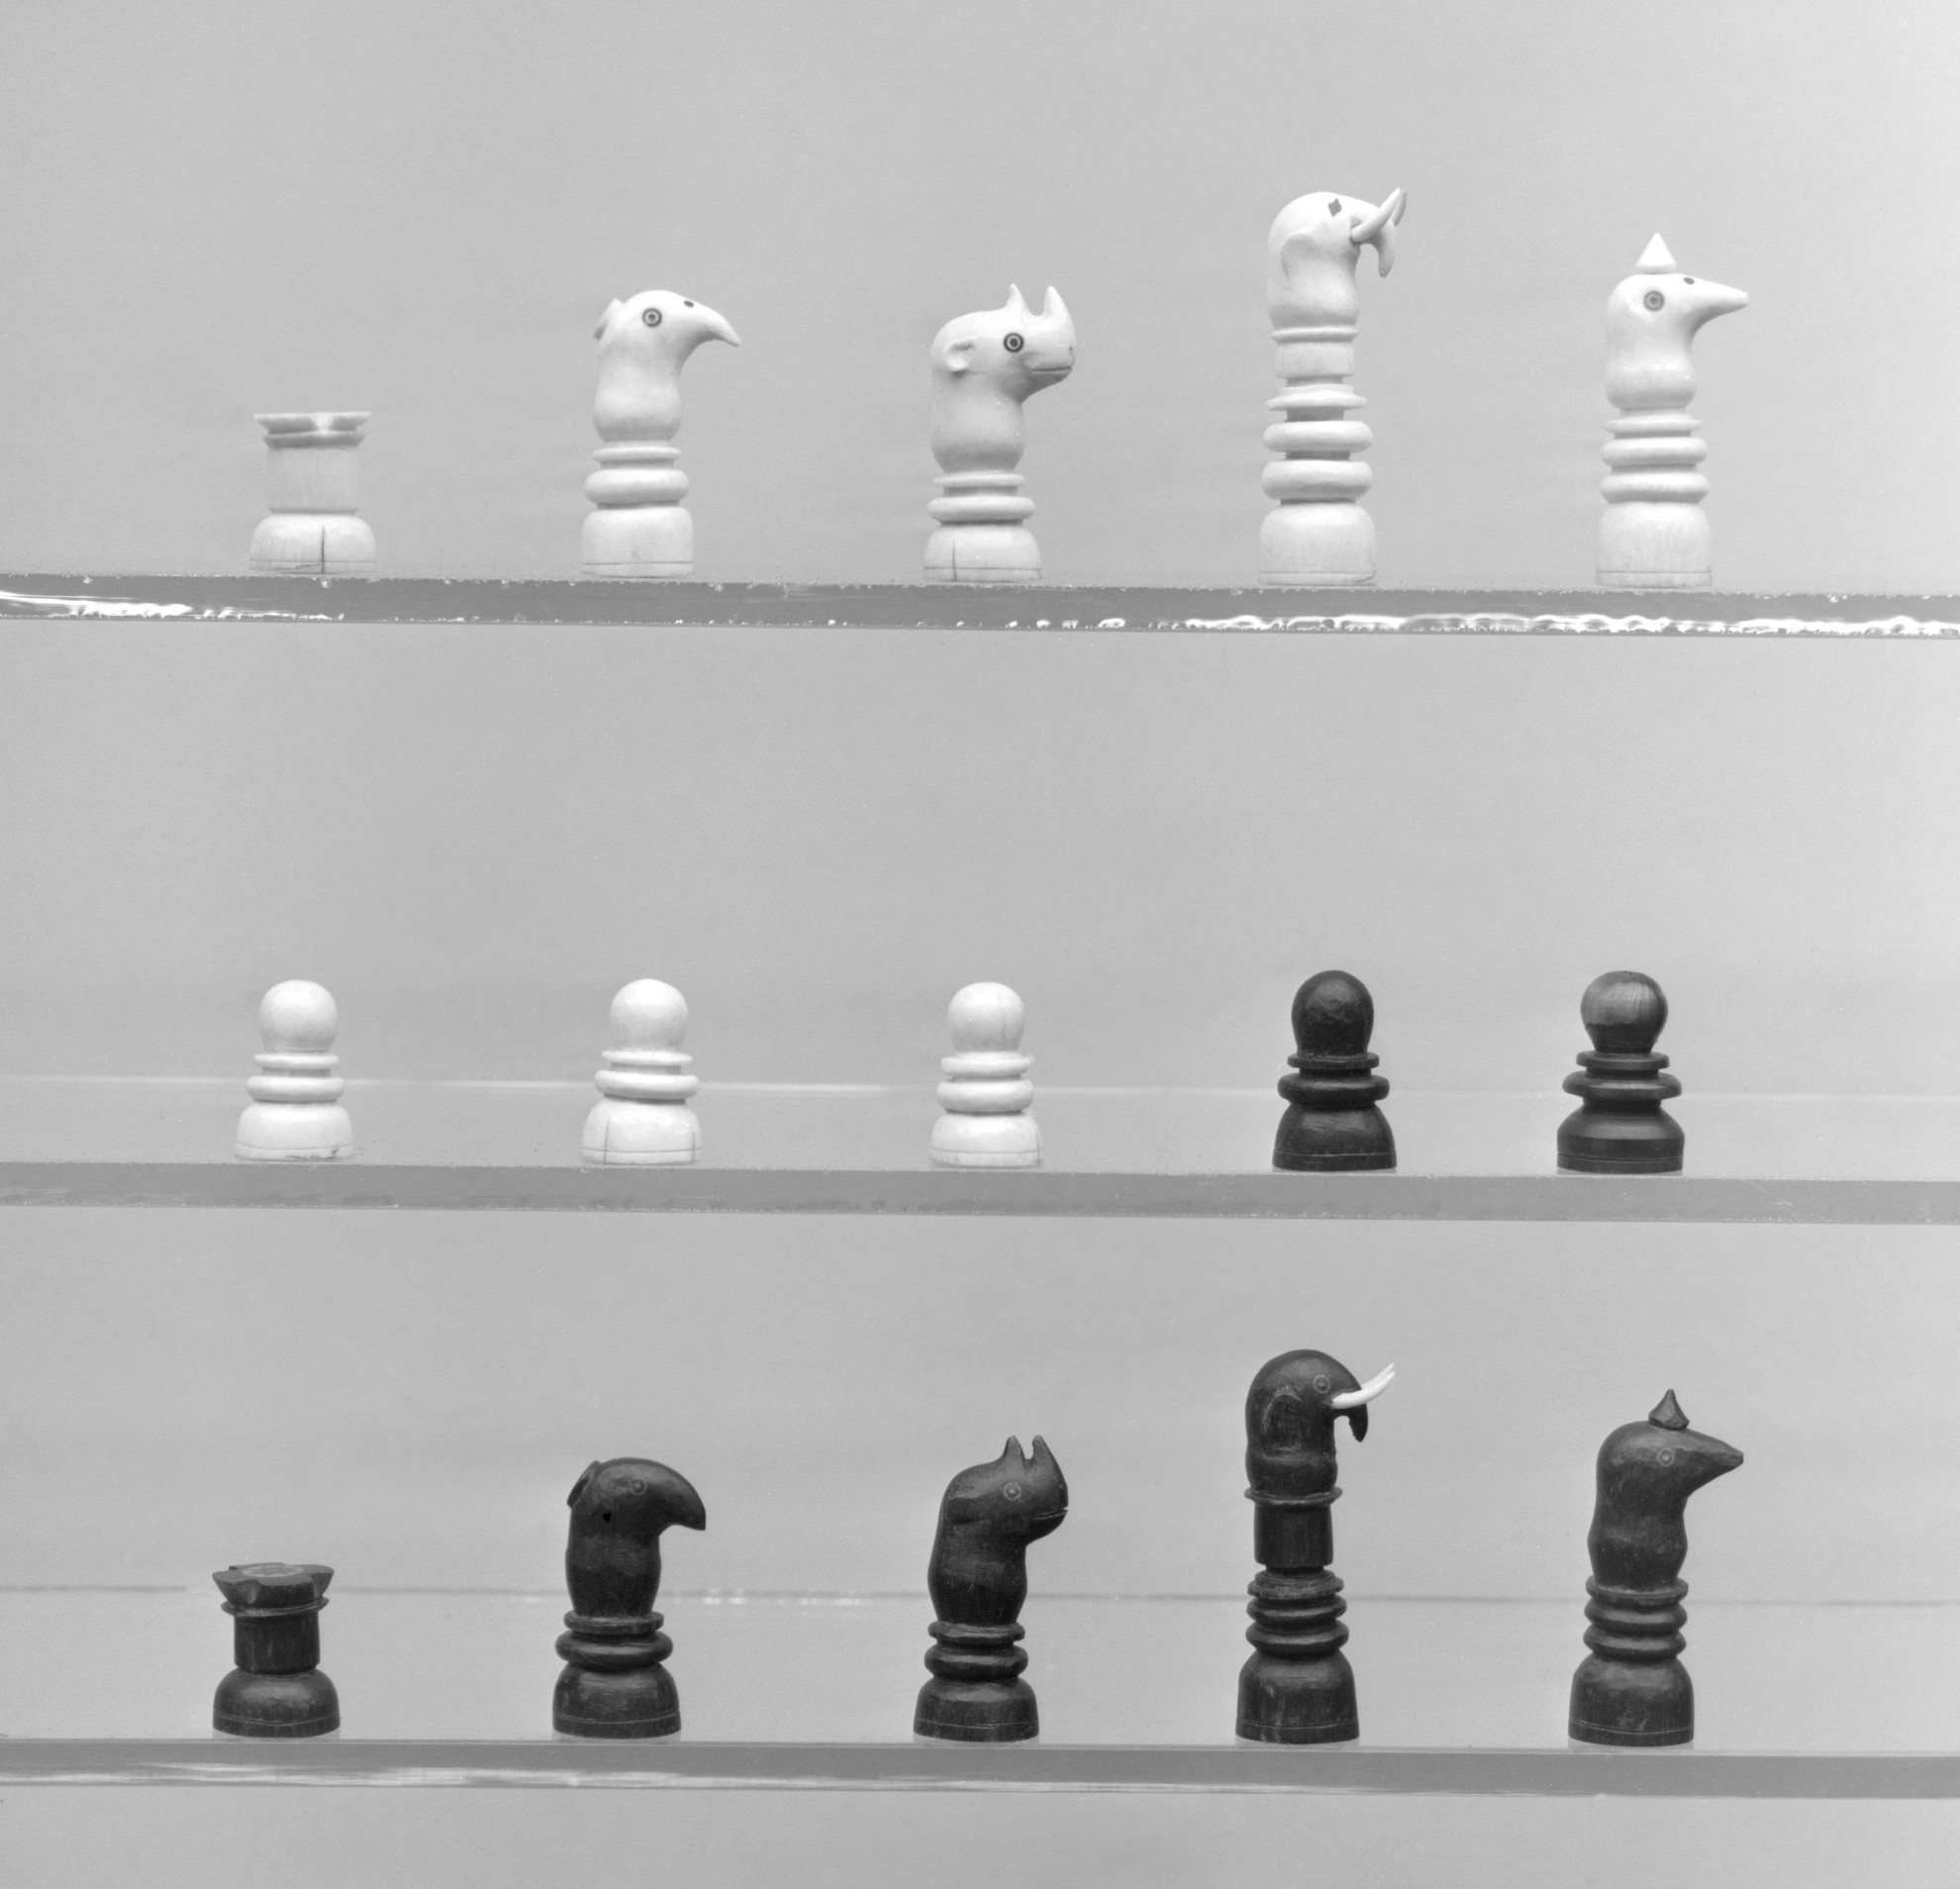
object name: chessman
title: Chessmen (32)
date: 1801-1900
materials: horn, ivory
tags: chess